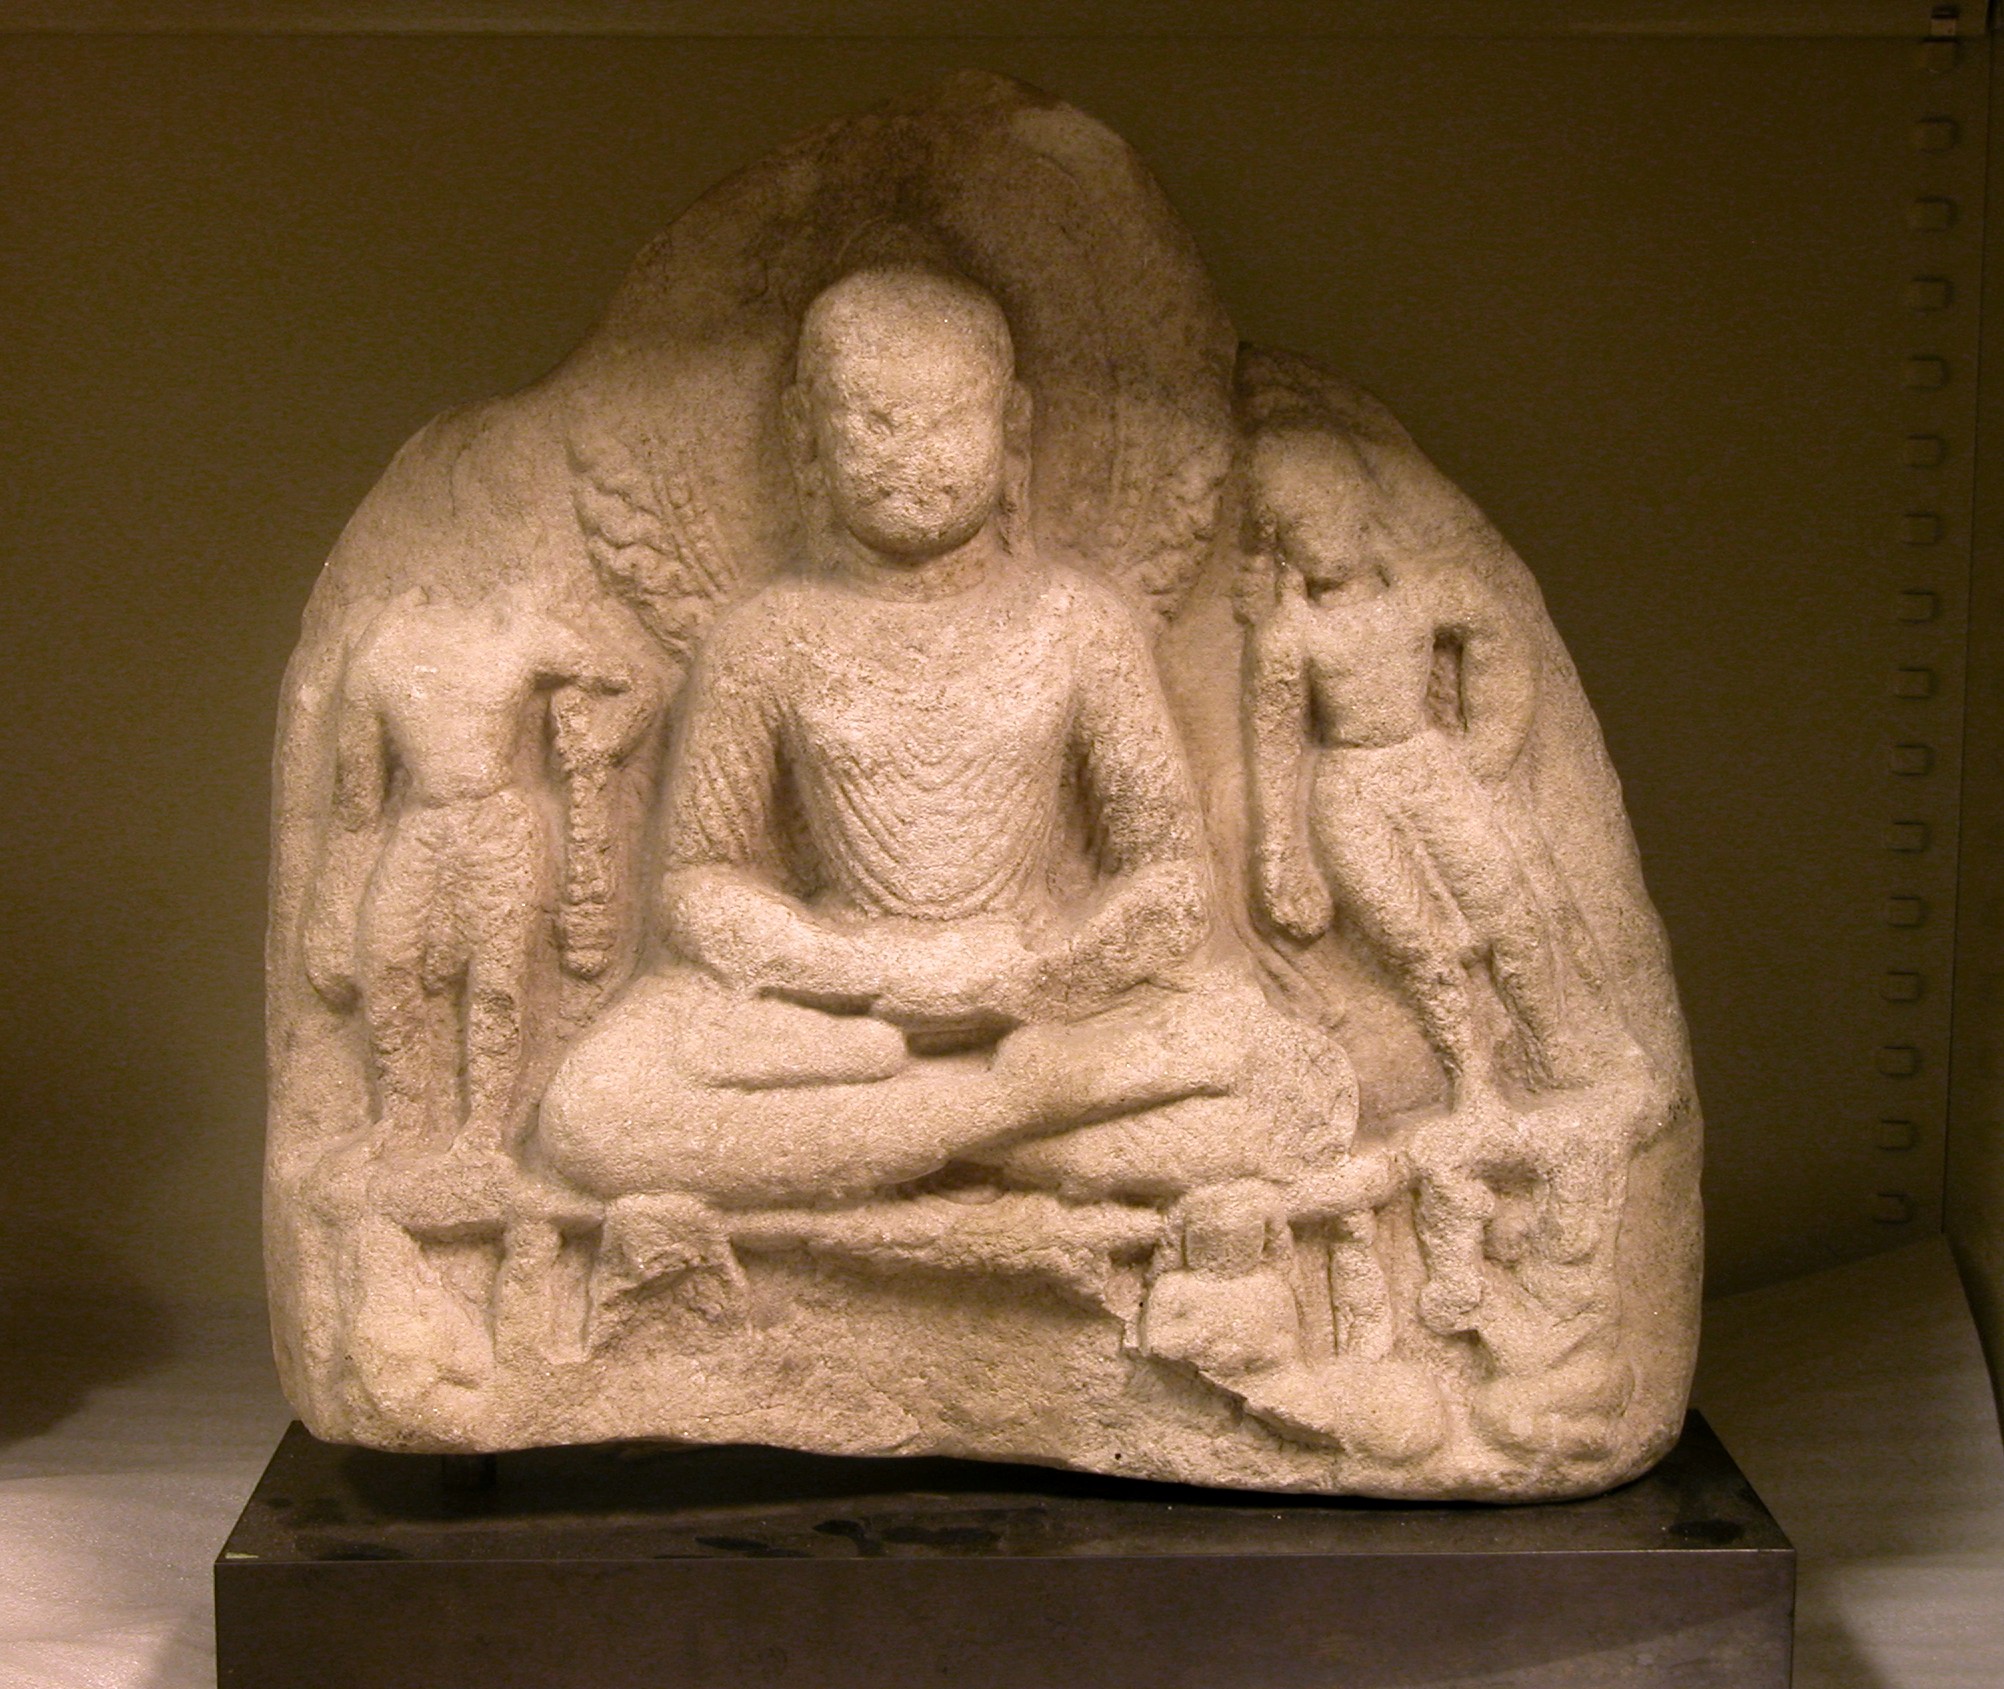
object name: stele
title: Meditating Buddha Attended by Two Bodhisattvas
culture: pakistani, swat valley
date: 601-800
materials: marble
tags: swat valley,buddhism,bodhisattvas,buddha